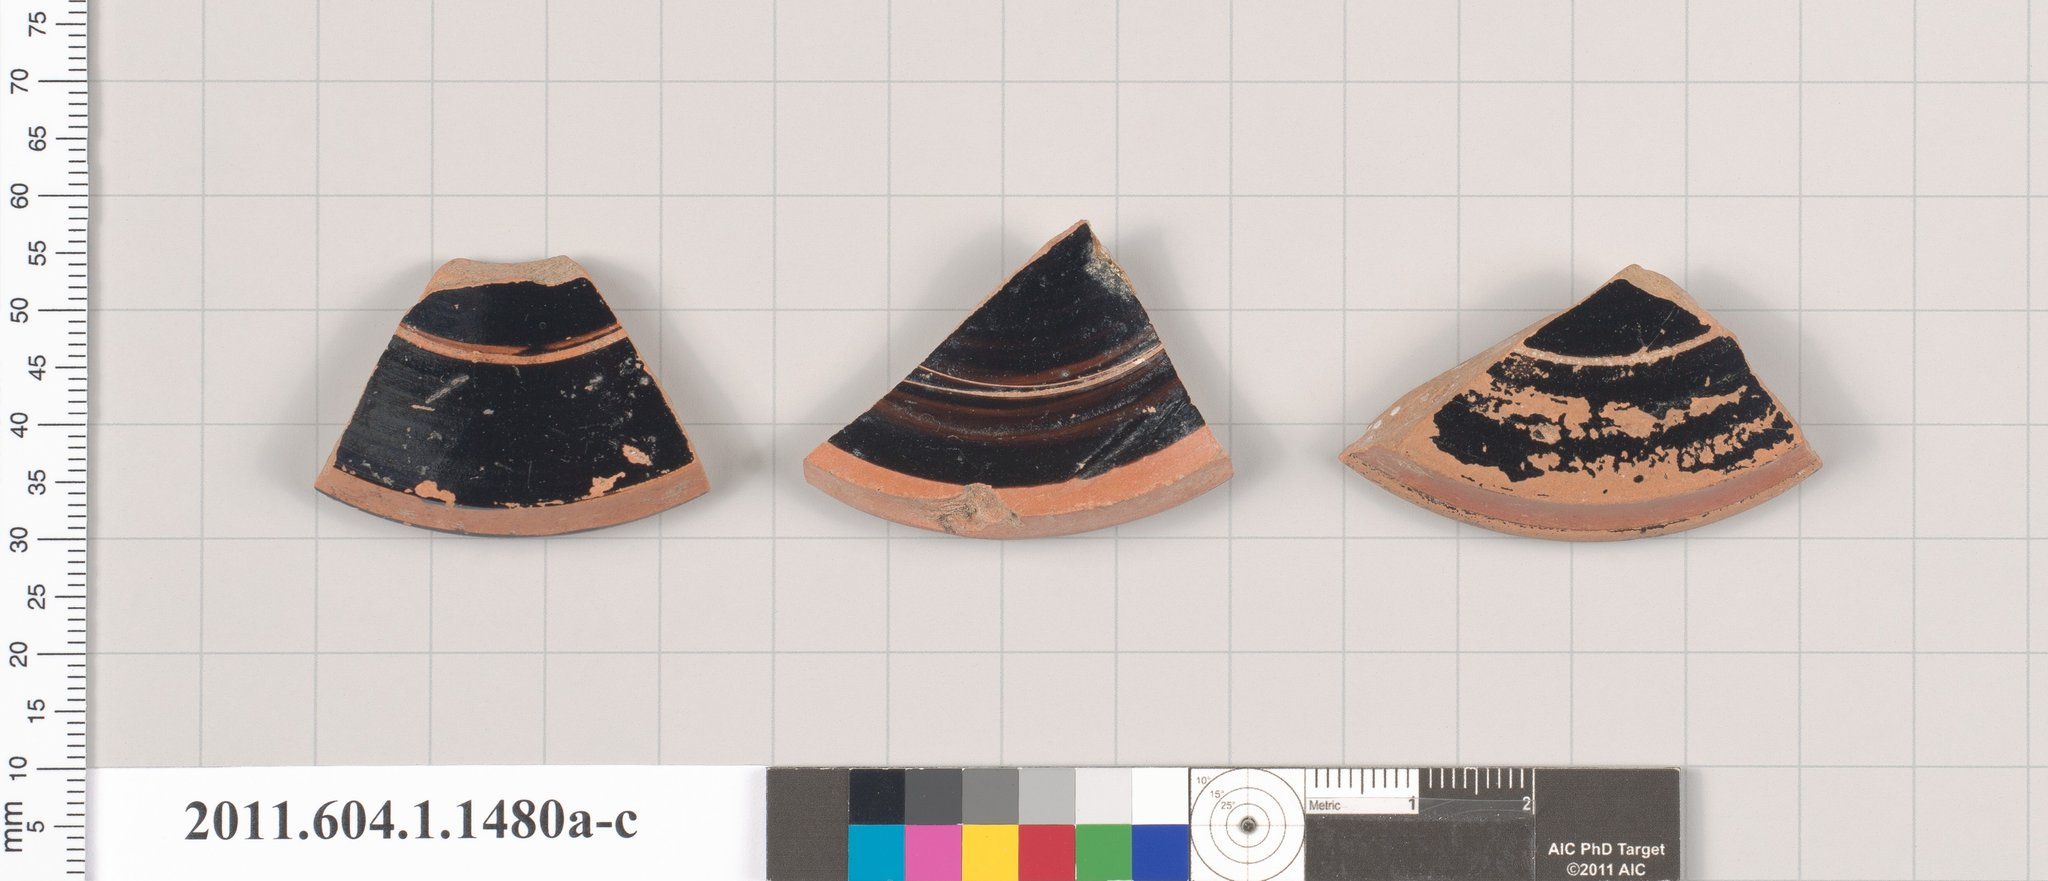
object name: kylix fragment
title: Terracotta fragments of kylikes (drinking cups)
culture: greek, attic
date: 500-401 BCE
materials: terracotta